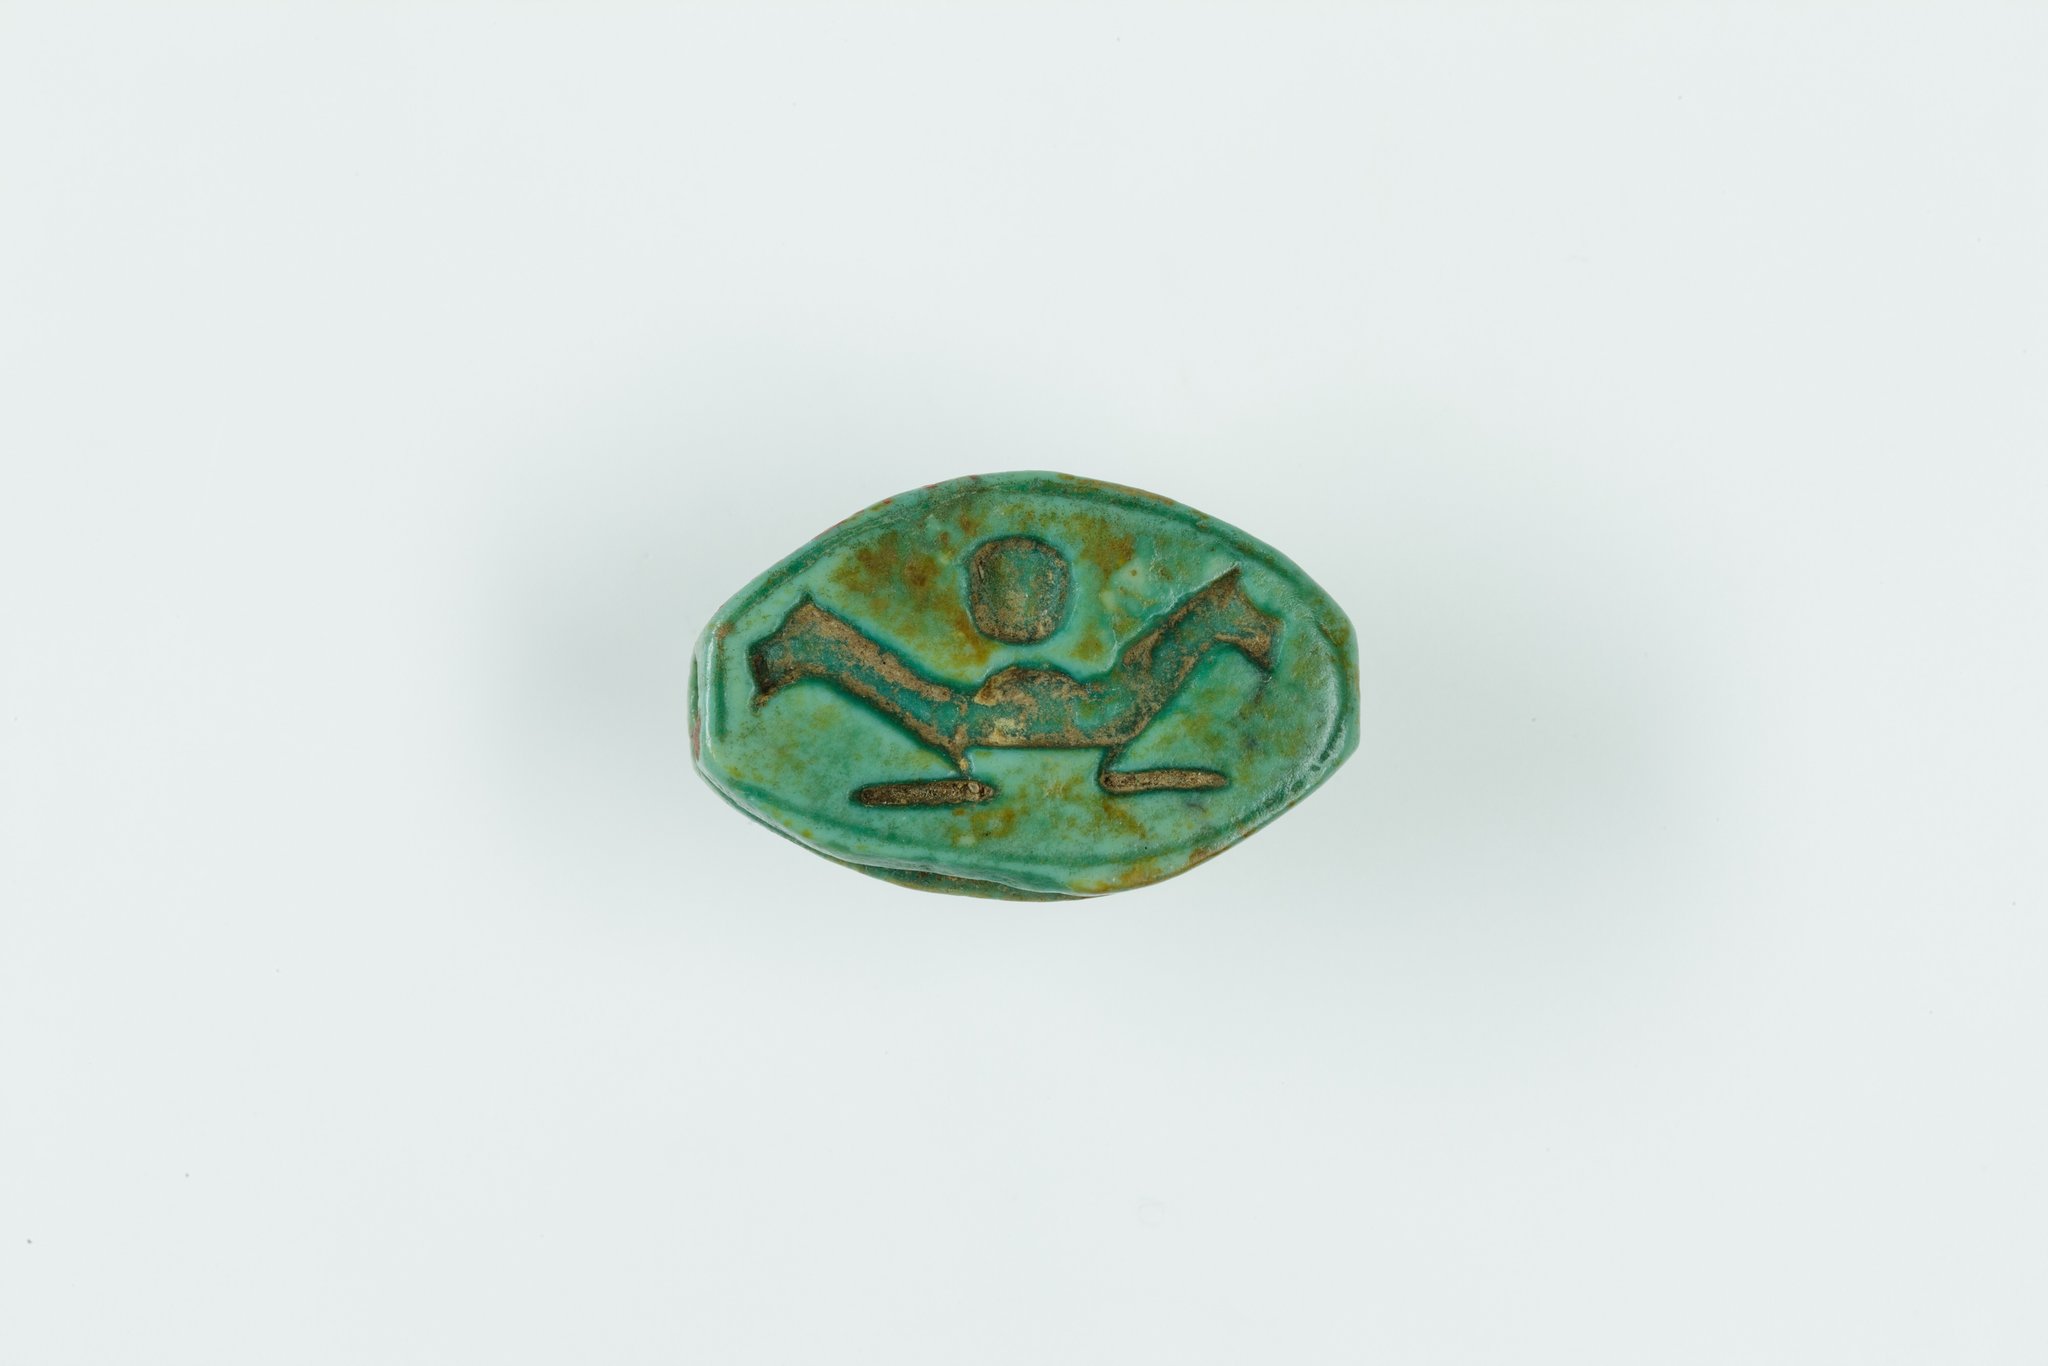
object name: scarab, khonsu, push me pull you animal, lion, sun disk, re, shu, tefnut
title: Cowroid with Outward-facing Merged Lions and Sun Disk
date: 1550-664 BCE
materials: stone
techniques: glazing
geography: egypt